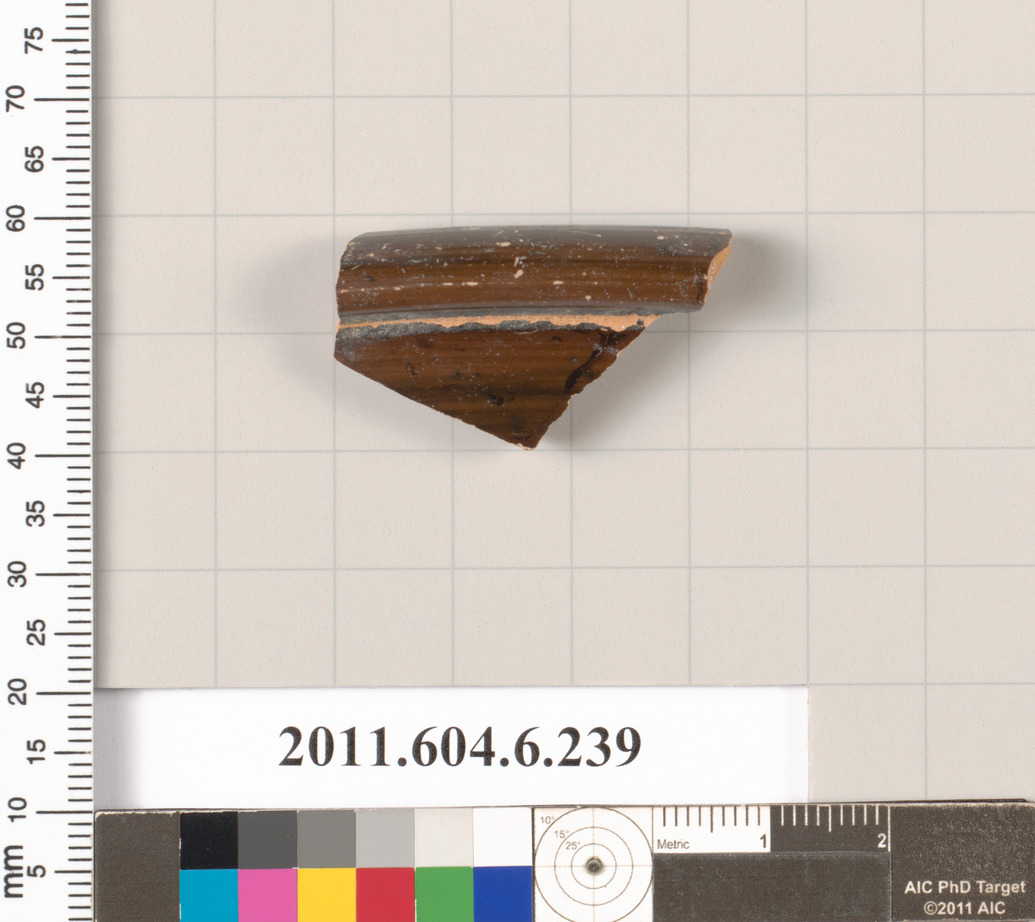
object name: fragment of a bowl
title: Terracotta fragment of a bowl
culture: greek, attic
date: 500-301 BCE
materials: terracotta